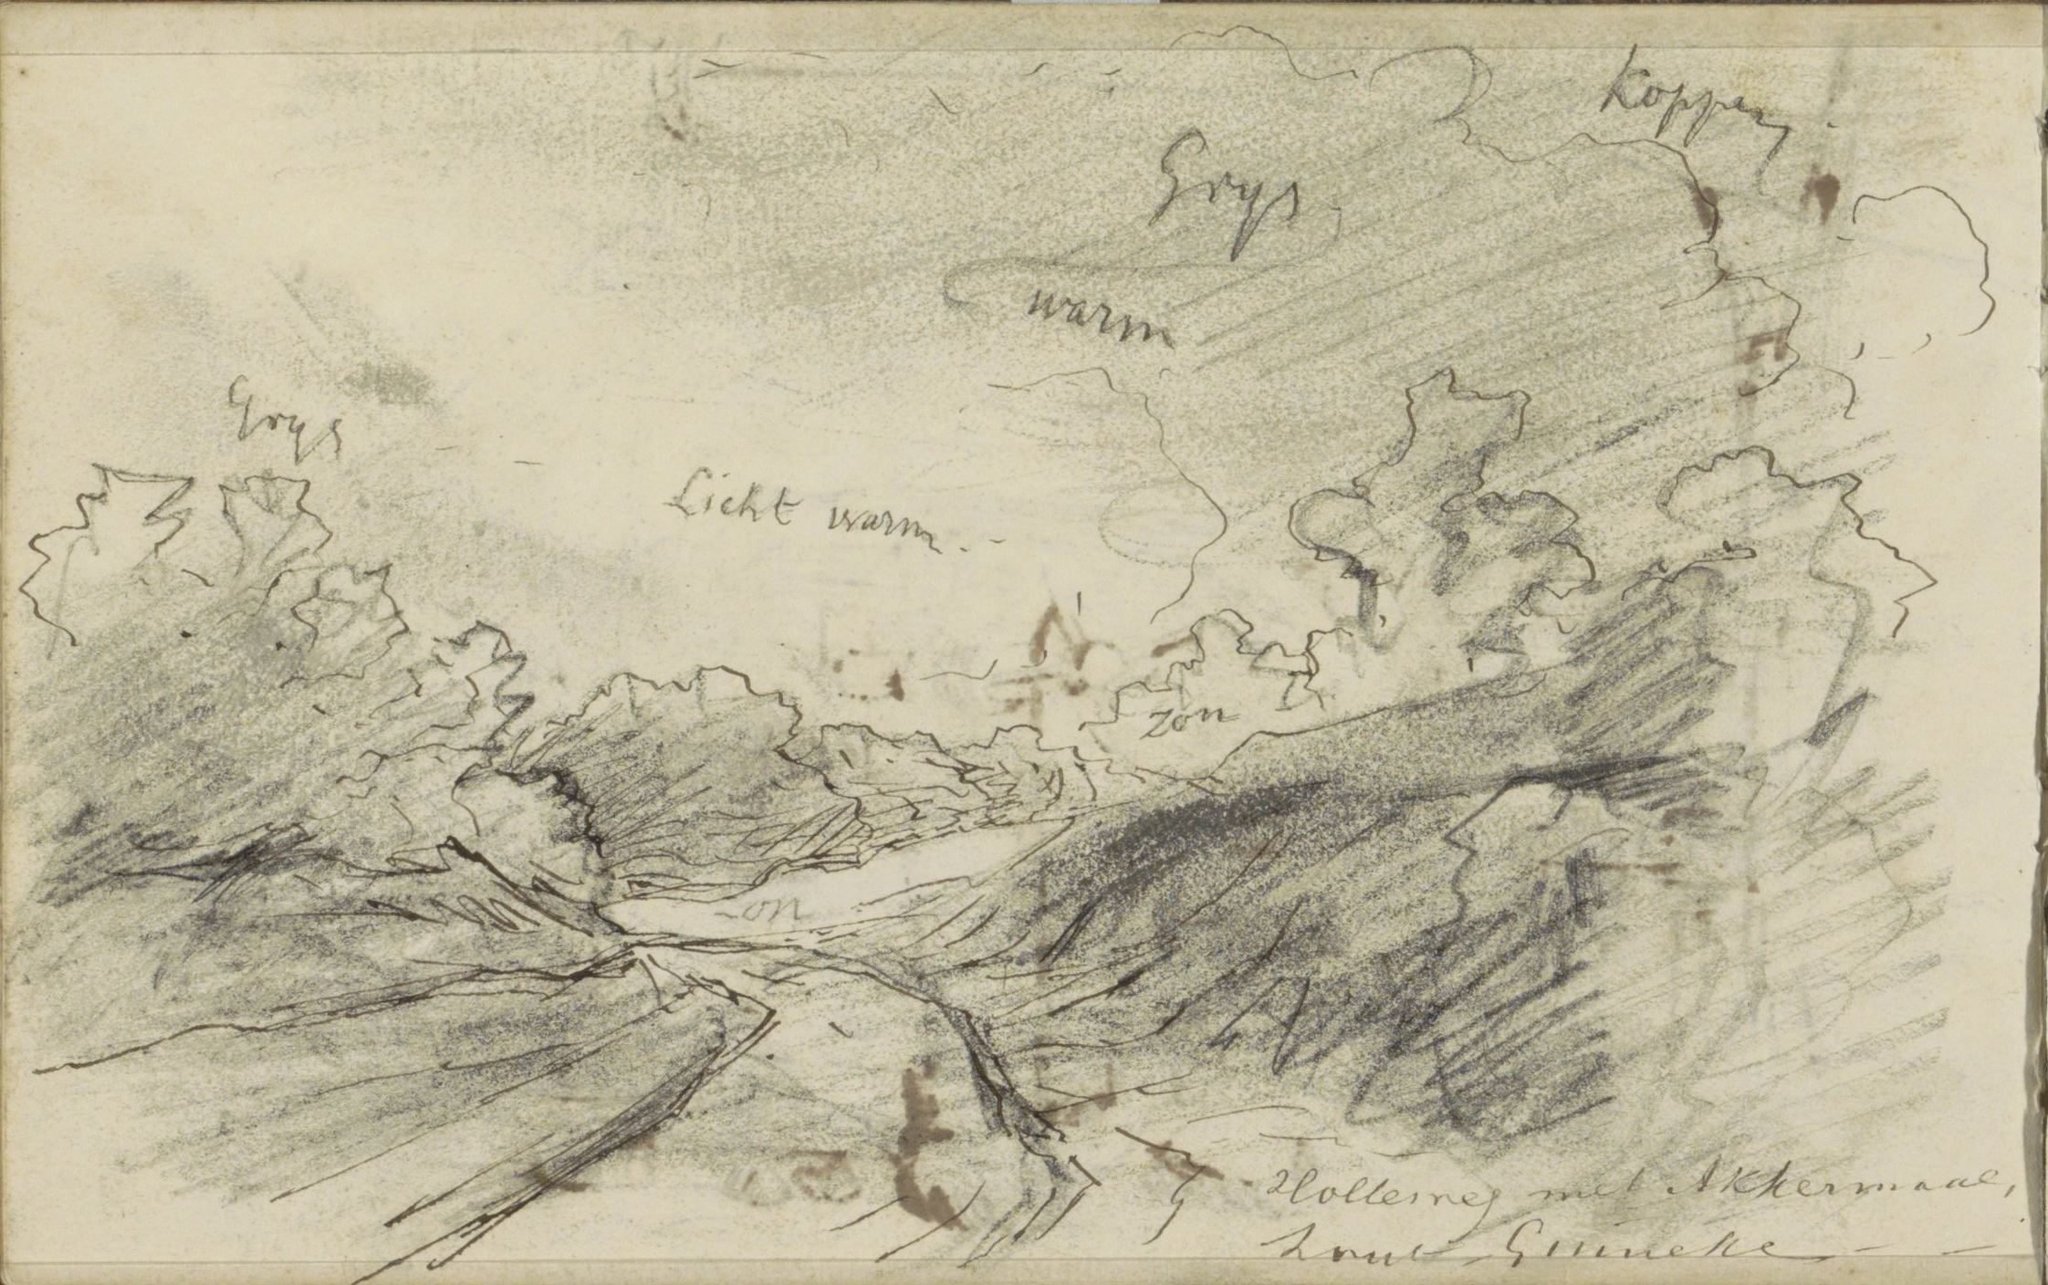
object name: sketchbook leaf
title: Landweg met afscheidingsheg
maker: johannes tavenraat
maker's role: draughtsman, painter, print maker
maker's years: 1809-1881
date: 1839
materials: paper, pencil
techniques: pen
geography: ginneken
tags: trees, shrubs, road, path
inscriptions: date and inscription: ‘Holleweg met Akkermaal,/ Zant - Ginneken -’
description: Blad 5 verso uit een schetsboek met 37 bladen.